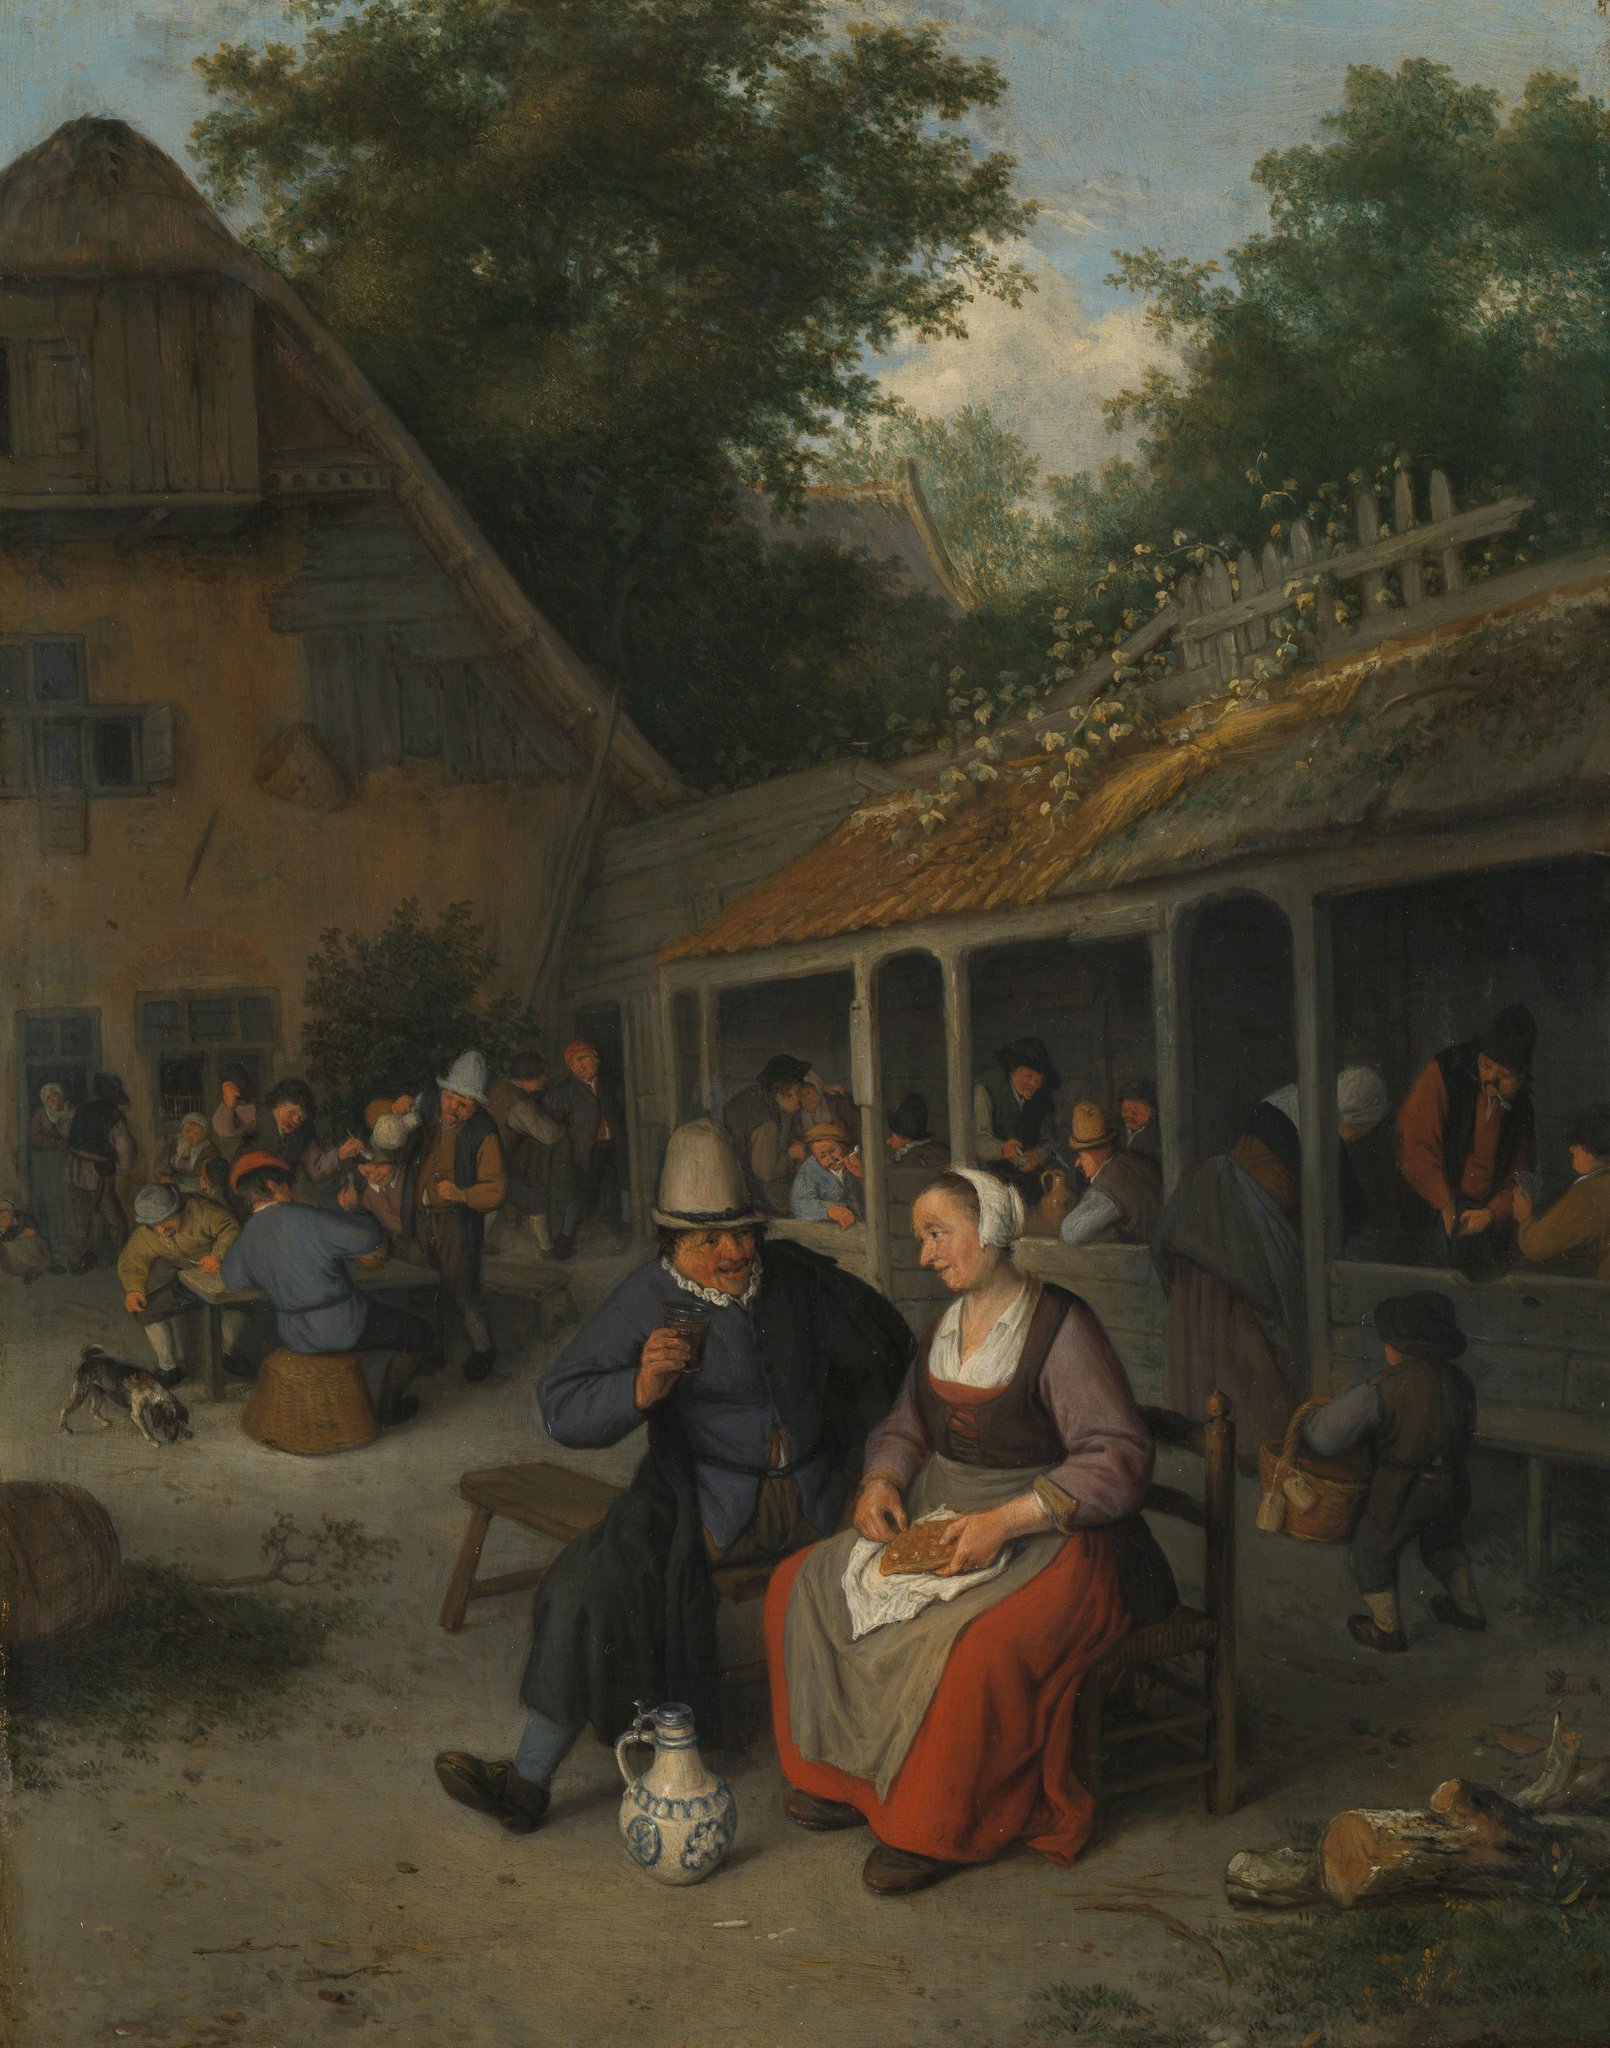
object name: painting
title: Country Inn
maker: cornelis dusart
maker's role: draughtsman, painter, print maker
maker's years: 1660-1704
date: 1690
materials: oil, panel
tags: farmers, pavement, terrace in front of inn or restaurant, alcoholic drinks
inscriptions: signature and date: ‘Cor. Dusart. 1690.’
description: Een boerenherberg. Op de voorgrond een zittende man en vrouw, op de grond een kruik. De man heeft een glas in de hand, de vrouw heeft een koek op een doek op haar schoot. Voor de herberg drinkende mannen rond een tafel, rechts een soort uitbouw waar meer gasten zitten.